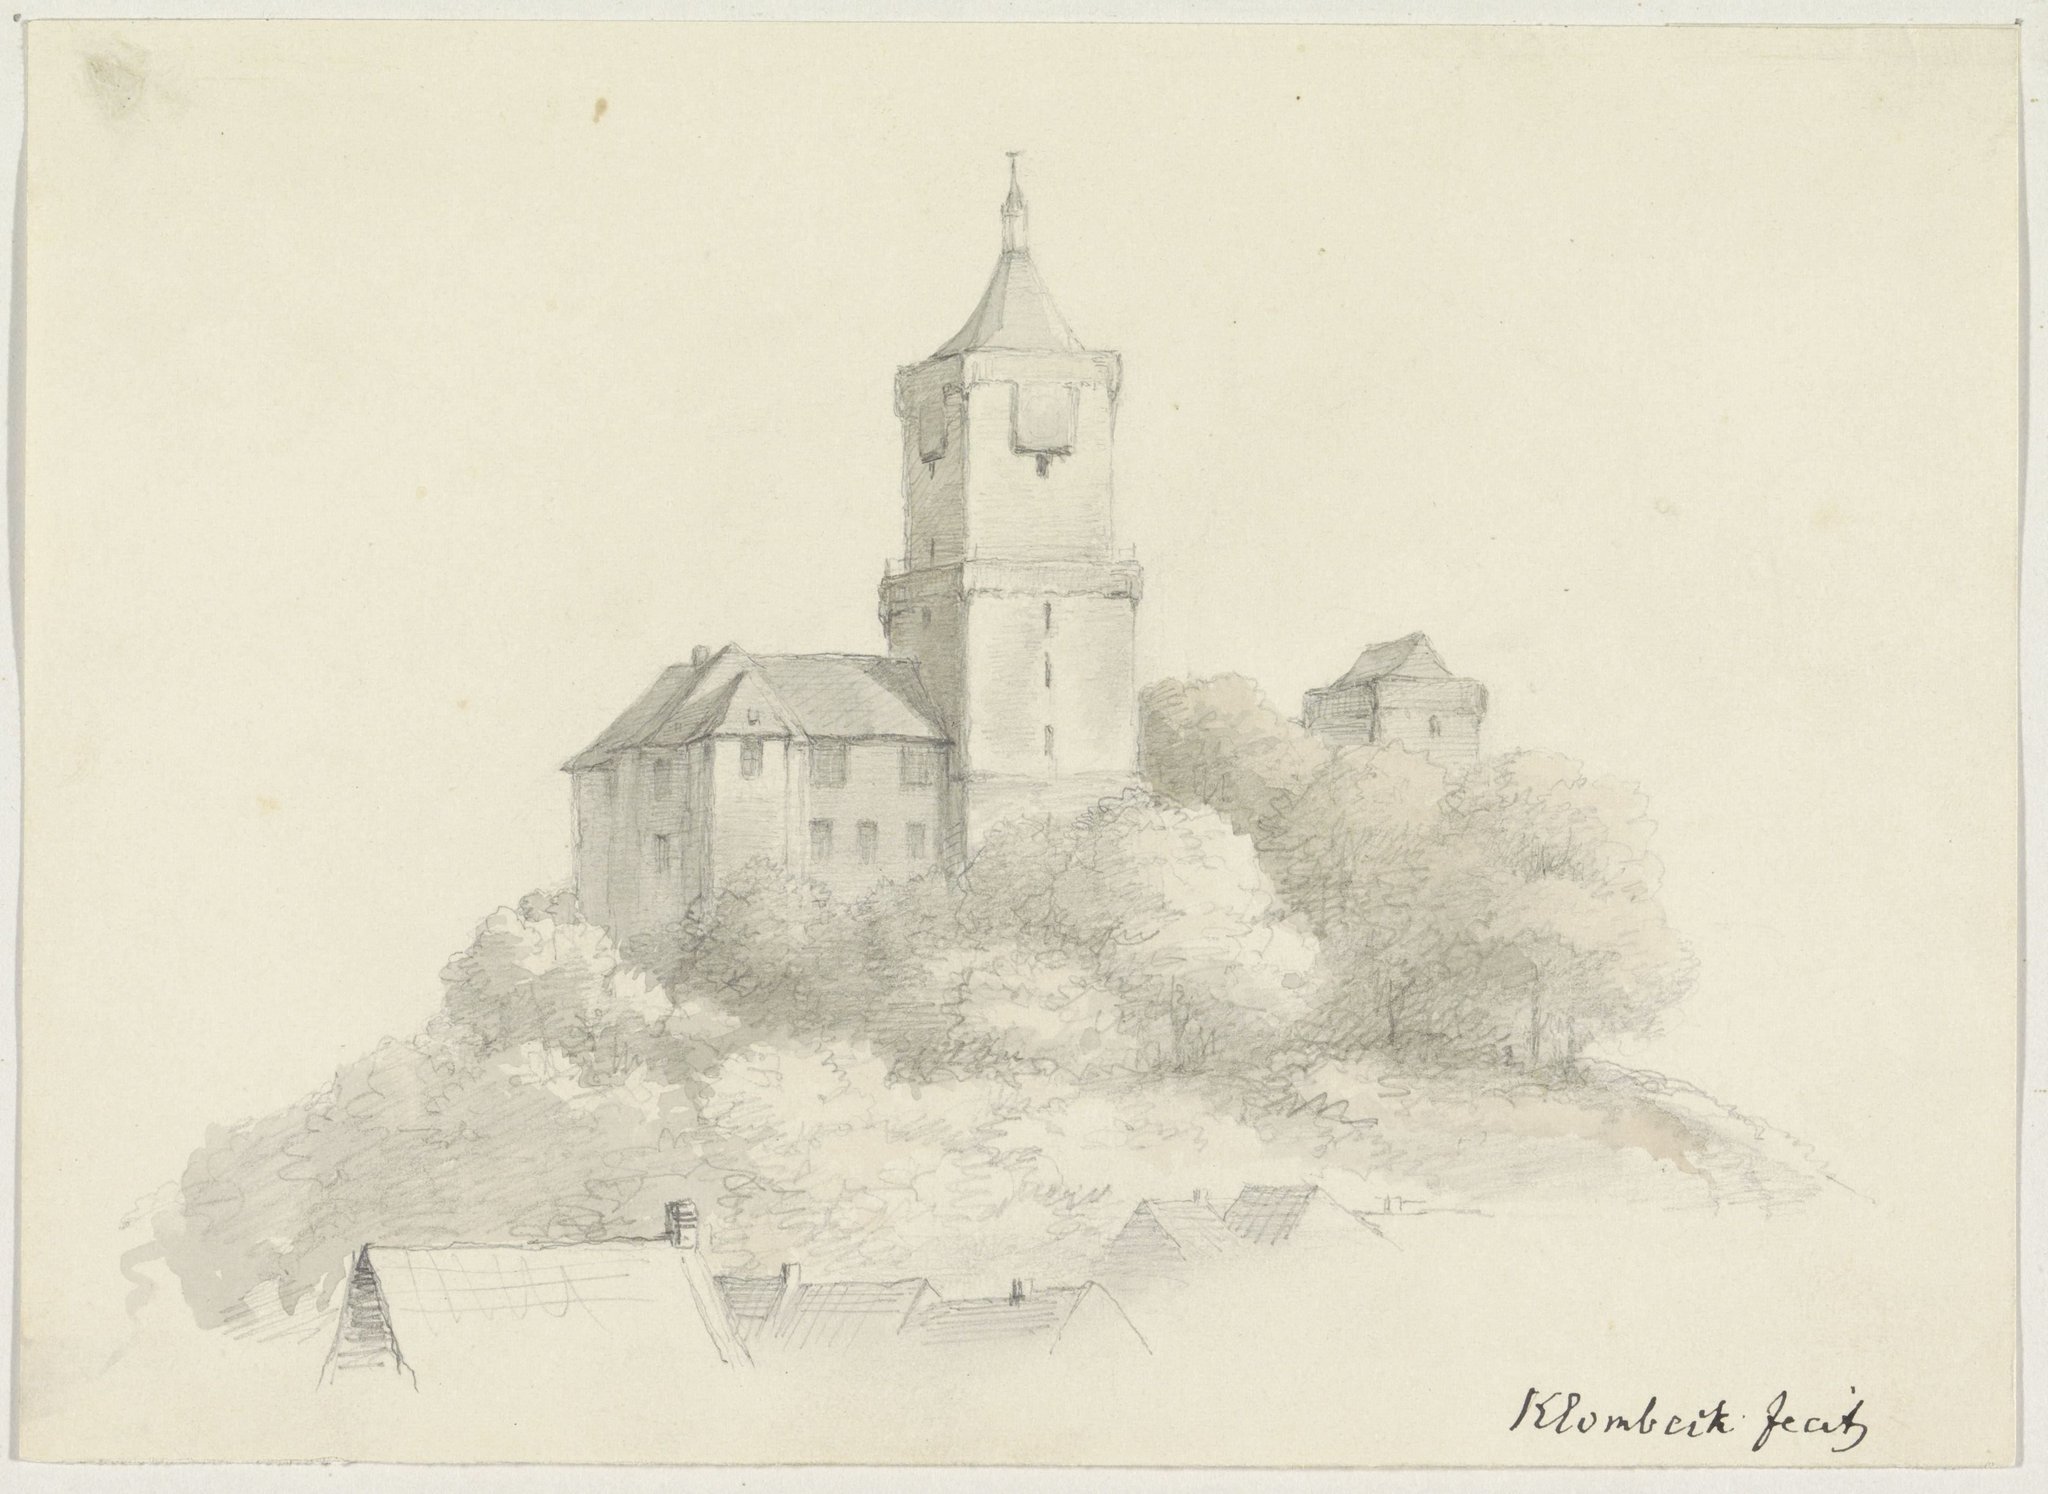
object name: drawing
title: Gezicht op de Zwanenburcht te Kleef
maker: johann bernard klombeek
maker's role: draughtsman, painter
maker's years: 1815-1893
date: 1825-1893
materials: paper, pencil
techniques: brush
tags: castle